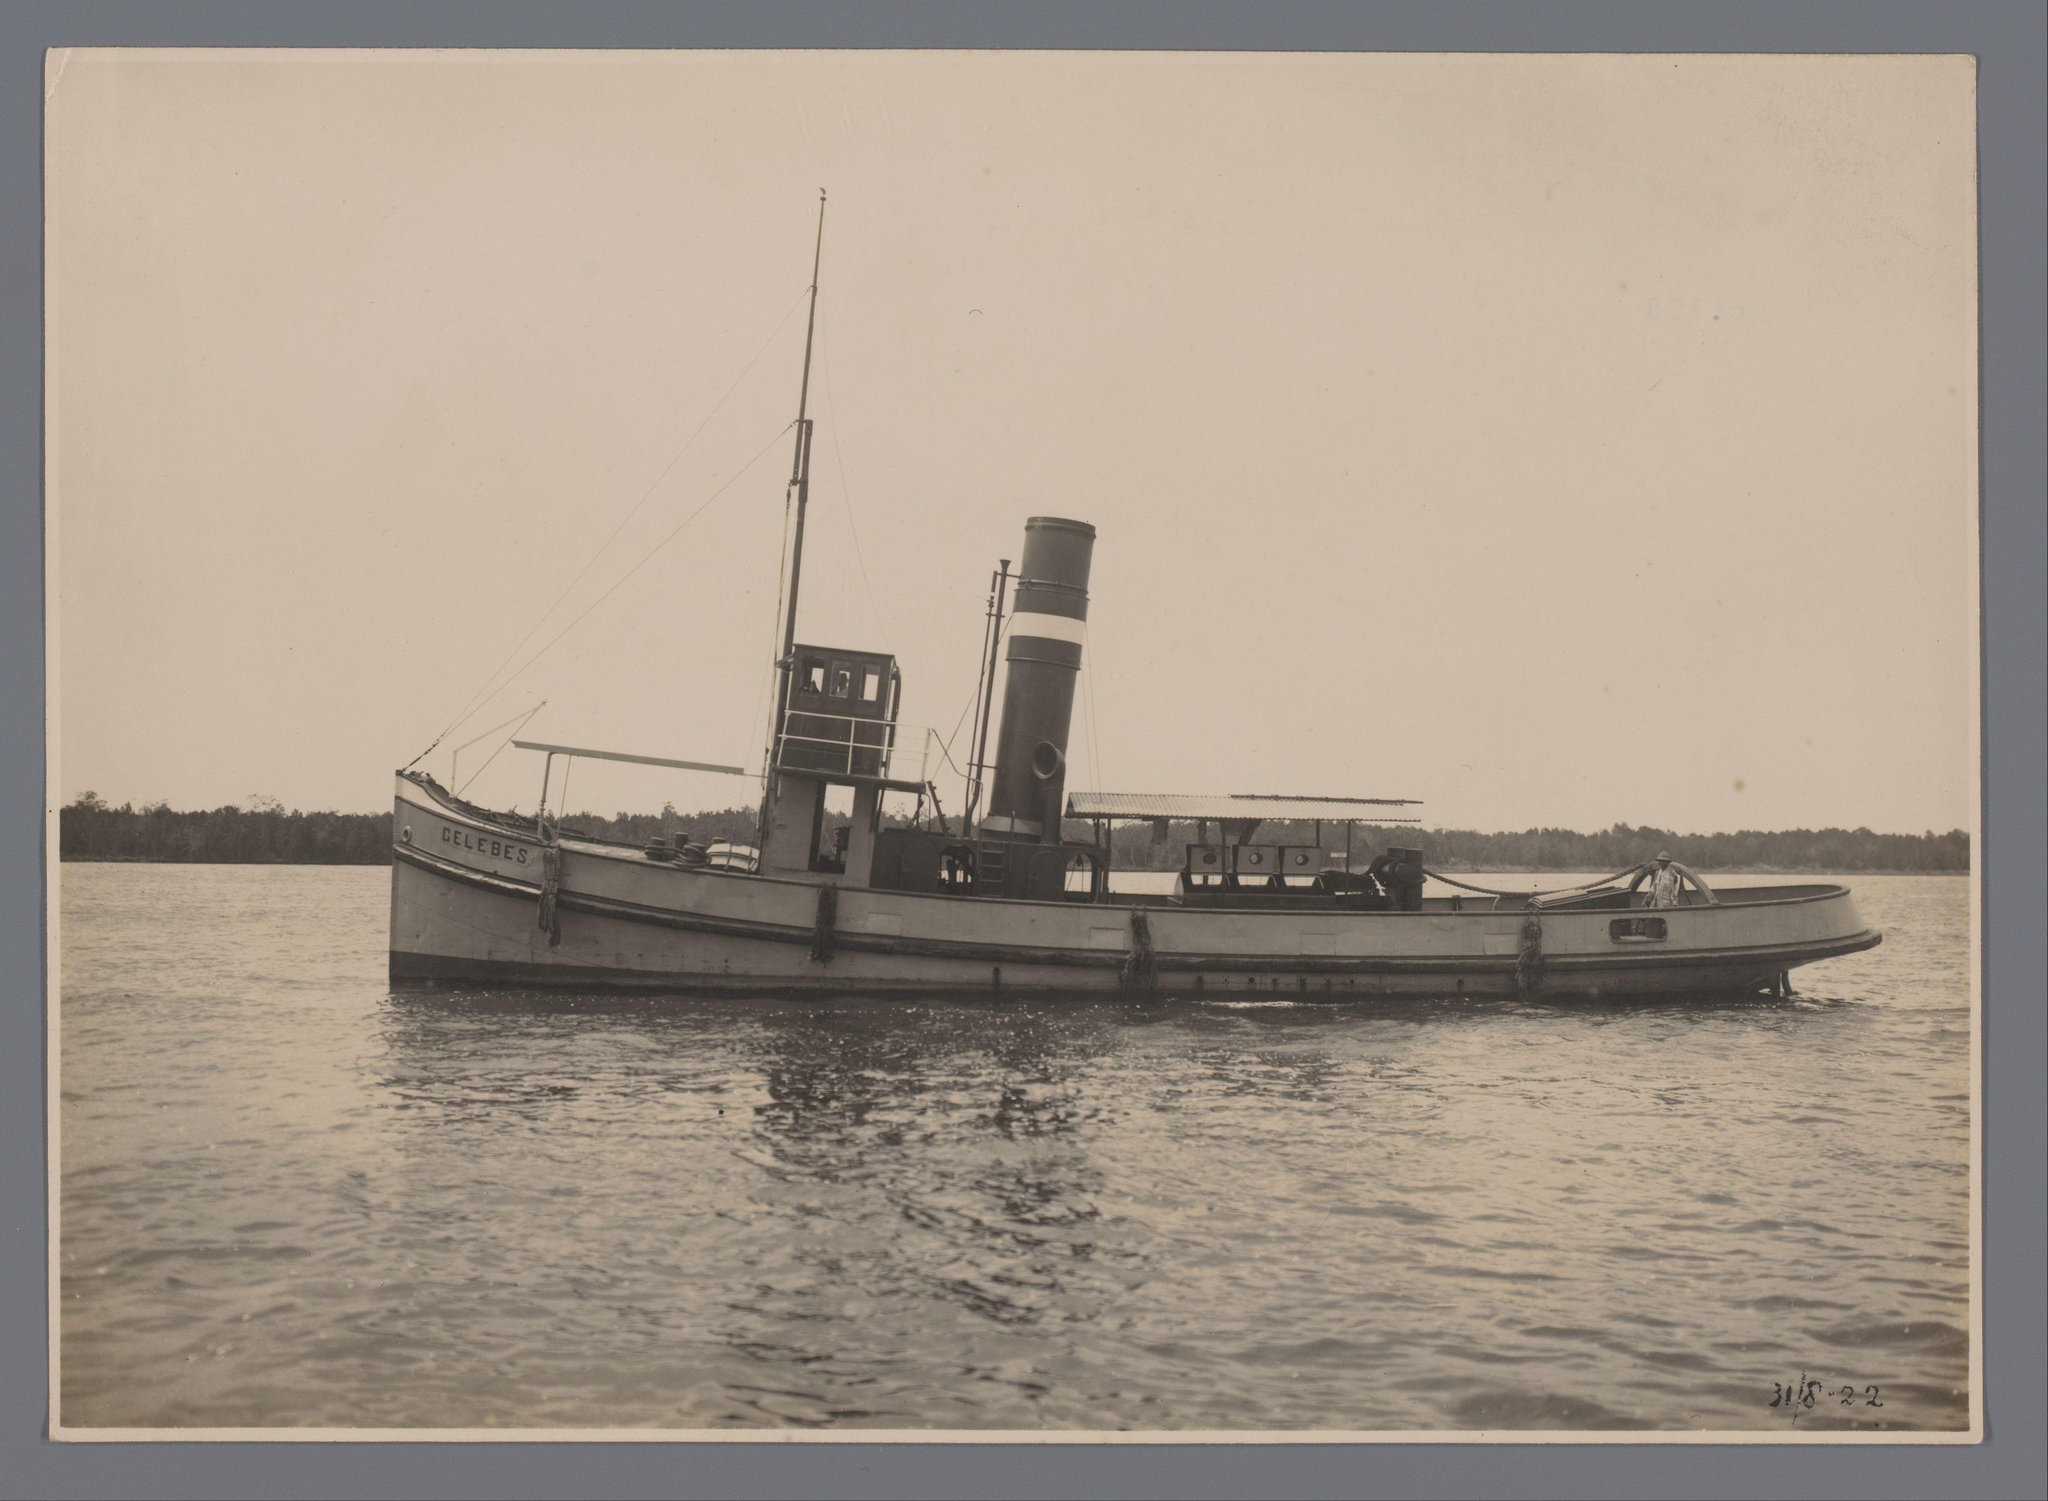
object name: photograph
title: Oceaanhaven Belawan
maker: Anonymous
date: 1922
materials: photographic support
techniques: gelatin silver print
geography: belawan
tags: harbour, building-site, tug, pusher tug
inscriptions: inscription: ‘No. 191 / Sleepboot "Celebes"’, date: ‘31/8-22’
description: De sleepboot 'Celebes'. Genummerd: 191. Onderdeel van de groep van losse foto's over de aanleg van de haven Belawan aan de kust voor Medan, Sumatra 1921-1922.